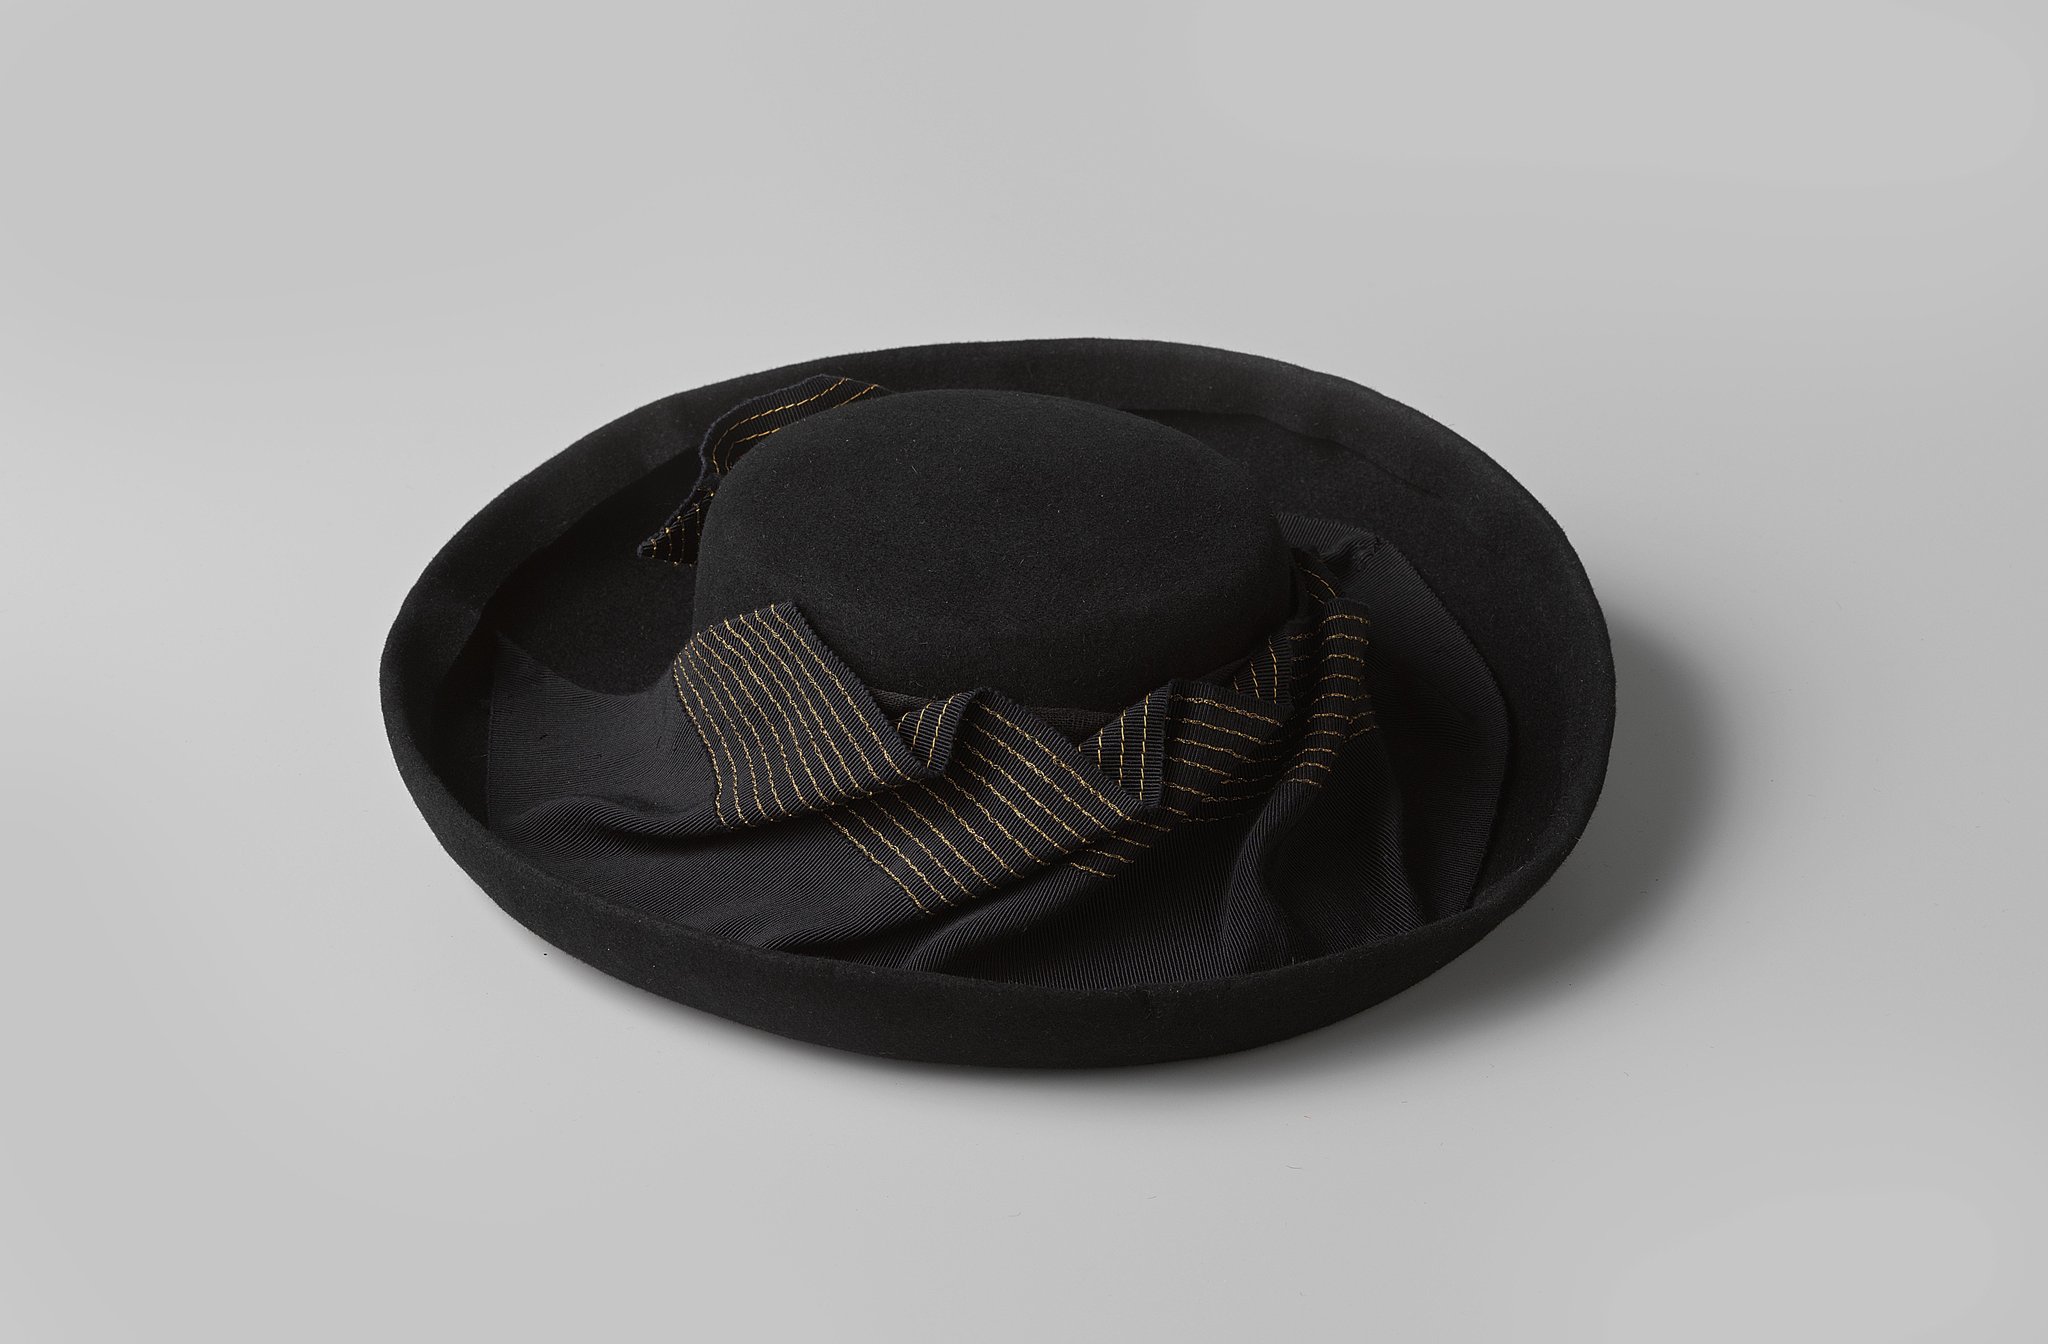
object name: hat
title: Hoed van zwart vilt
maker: Anonymous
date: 1935-1940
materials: felt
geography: netherlands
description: Hoed van zwart vilt met twee verwisselbare linten, een zwart met gestreepte gouddraad en een zwart met blauw. Door middel van drukknoopjes te vervangen. Passend bij middagjapon met ceintuur van bluawe en zwarte crêpe (BK-1984-154-A,B).